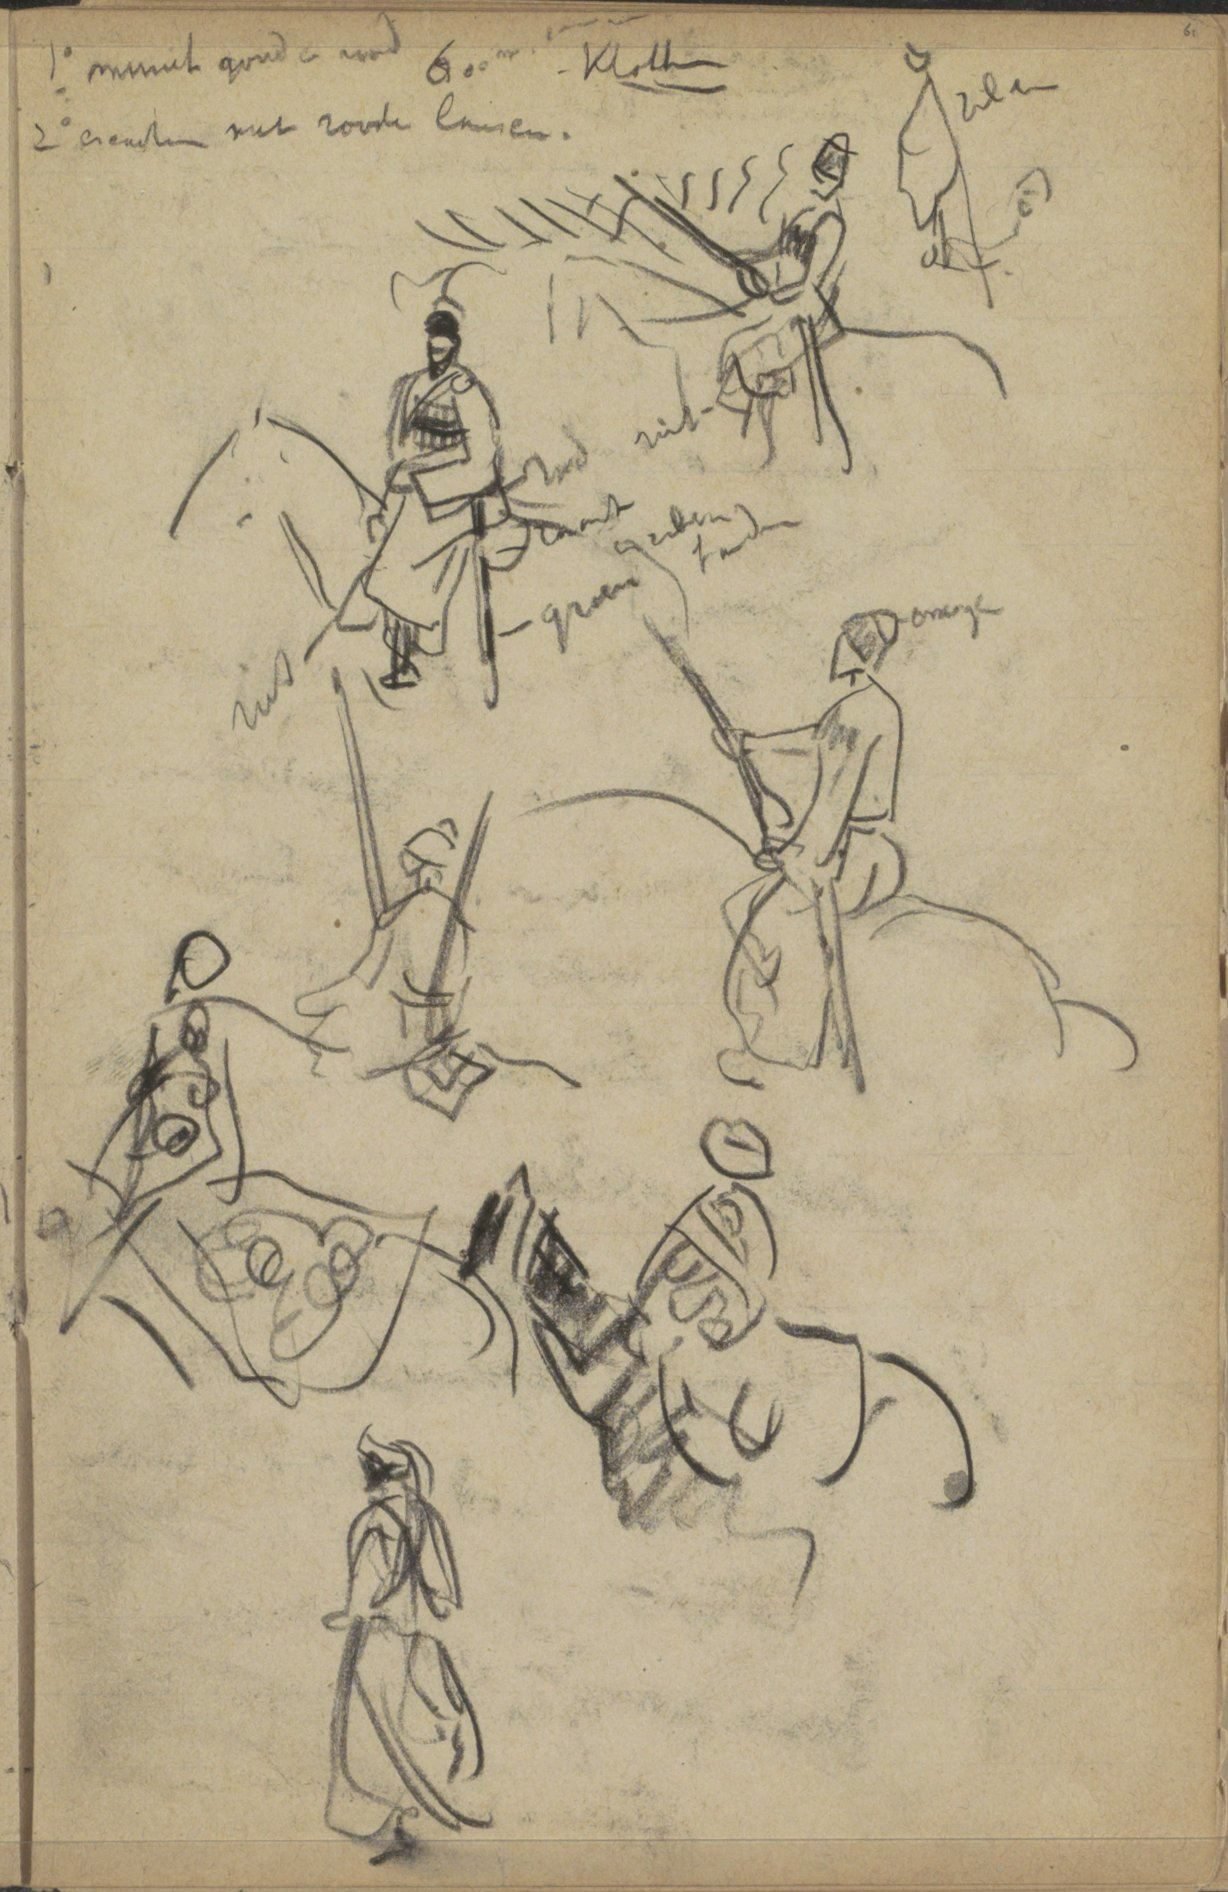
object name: sketchbook leaf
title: Militairen te paard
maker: marius bauer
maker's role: draughtsman, print maker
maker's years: 1867-1932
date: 1896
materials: chalk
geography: moscow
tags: riding a horse, ass, or mule; rider, horseman, folk costume, regional costume, (military) uniforms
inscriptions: annotation: ‘[...]’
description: Tevens een studie van een staande man in oosterse kleding. Pagina 61 uit een schetsboek met 50 bladen.